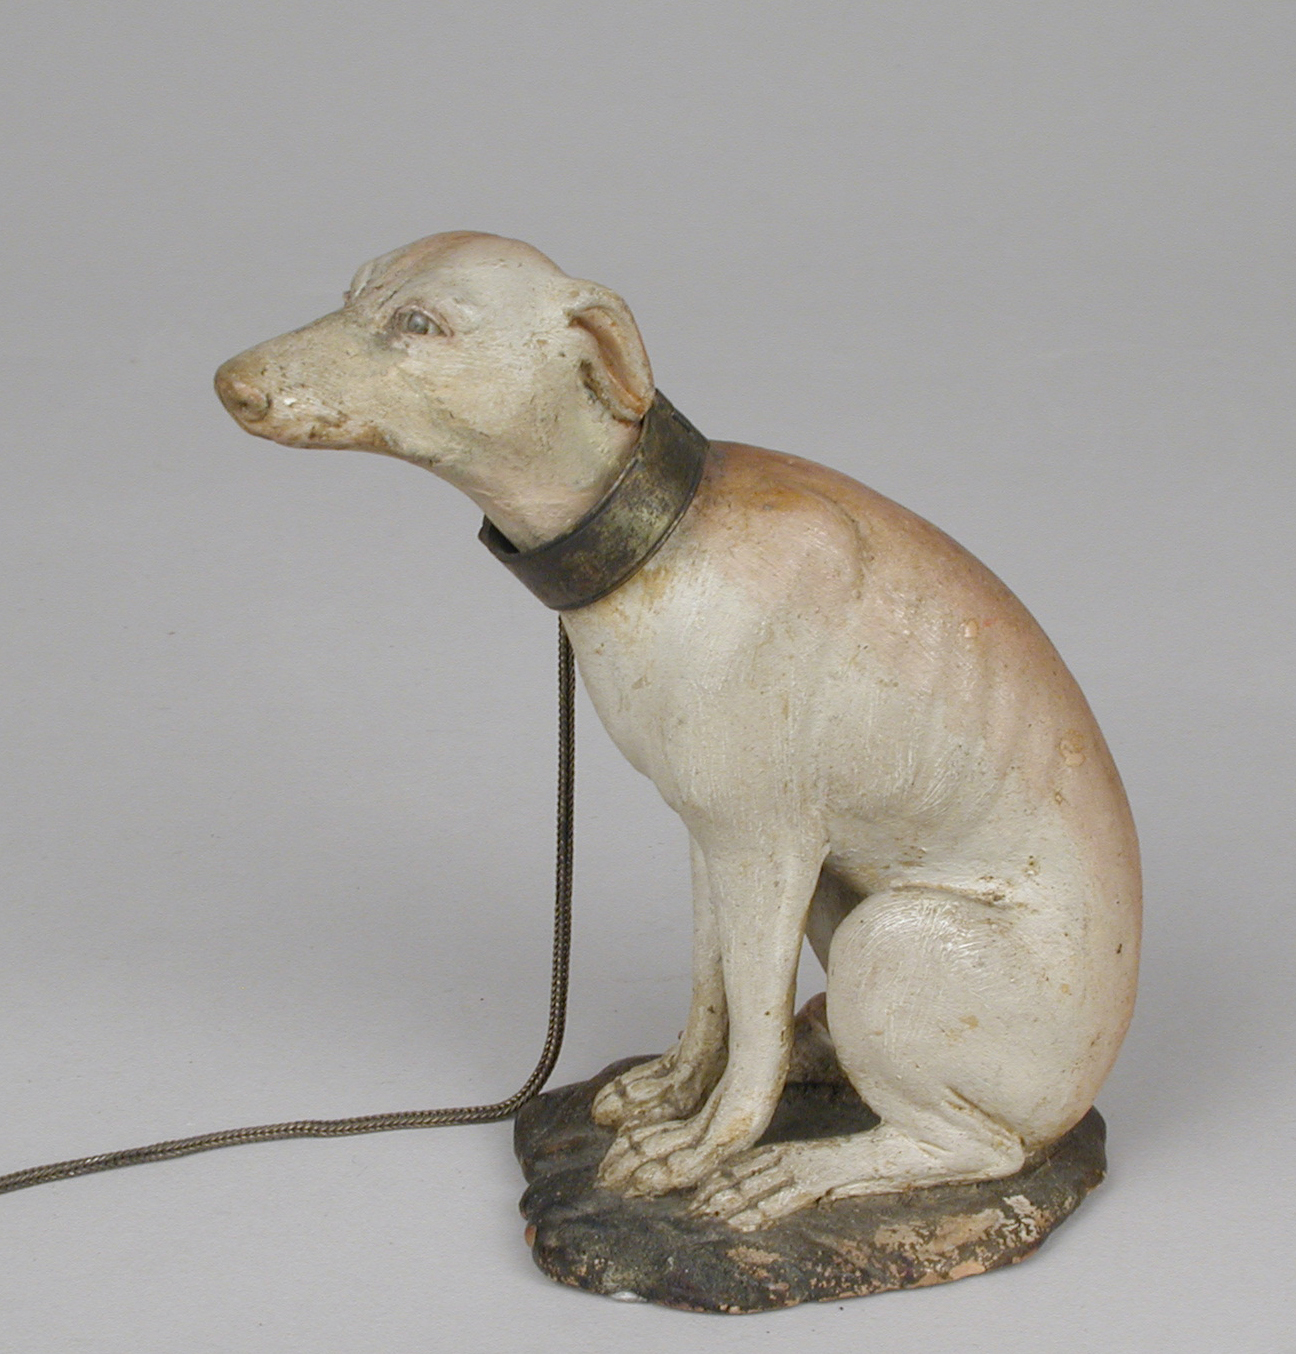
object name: crèche figure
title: Seated hound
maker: saverio vassalo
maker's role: maker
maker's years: 1725-1825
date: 1701-1900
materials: silver, terracotta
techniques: polychrome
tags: dogs